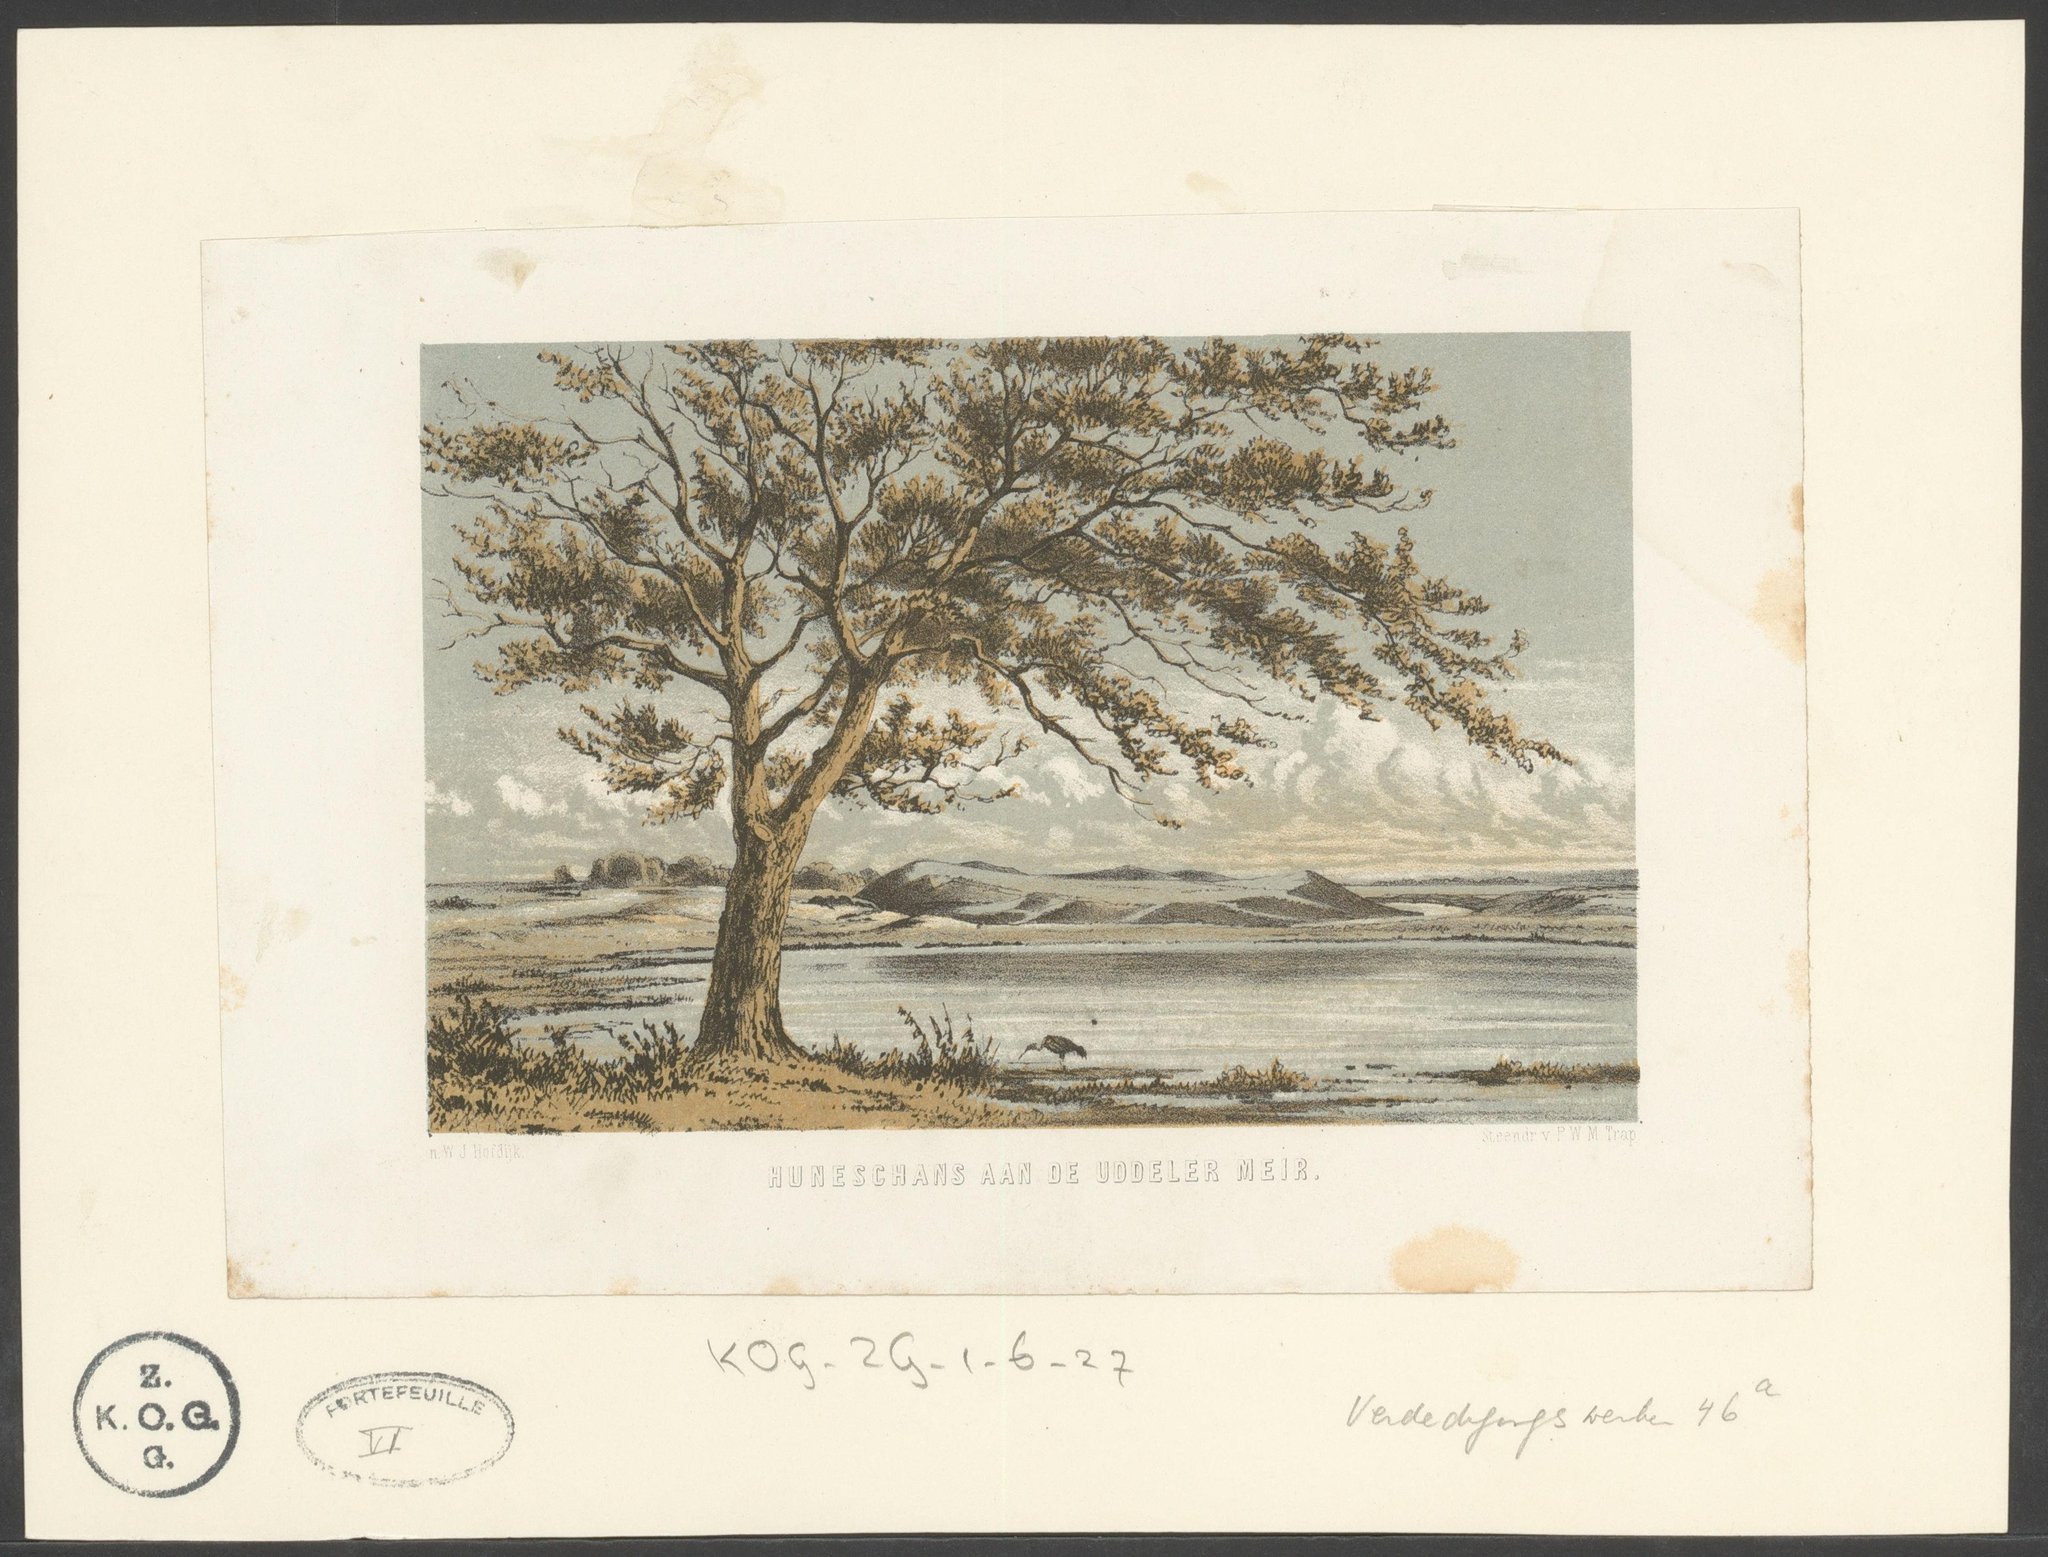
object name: print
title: Gezicht op de Hunneschans en het Uddelermeer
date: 1873-1875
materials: paper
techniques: tone lithography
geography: leiden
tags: hunnenschans, uddelermeer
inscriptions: stamp, collector's mark: Lugt 1641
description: Prent waarschijnlijk uit: Hofdijk, W.J. Ons voorgeslacht in zijn dagelyksch leven geschilderd. Tweede druk. Leiden: P. van Santen, ca. 1875.